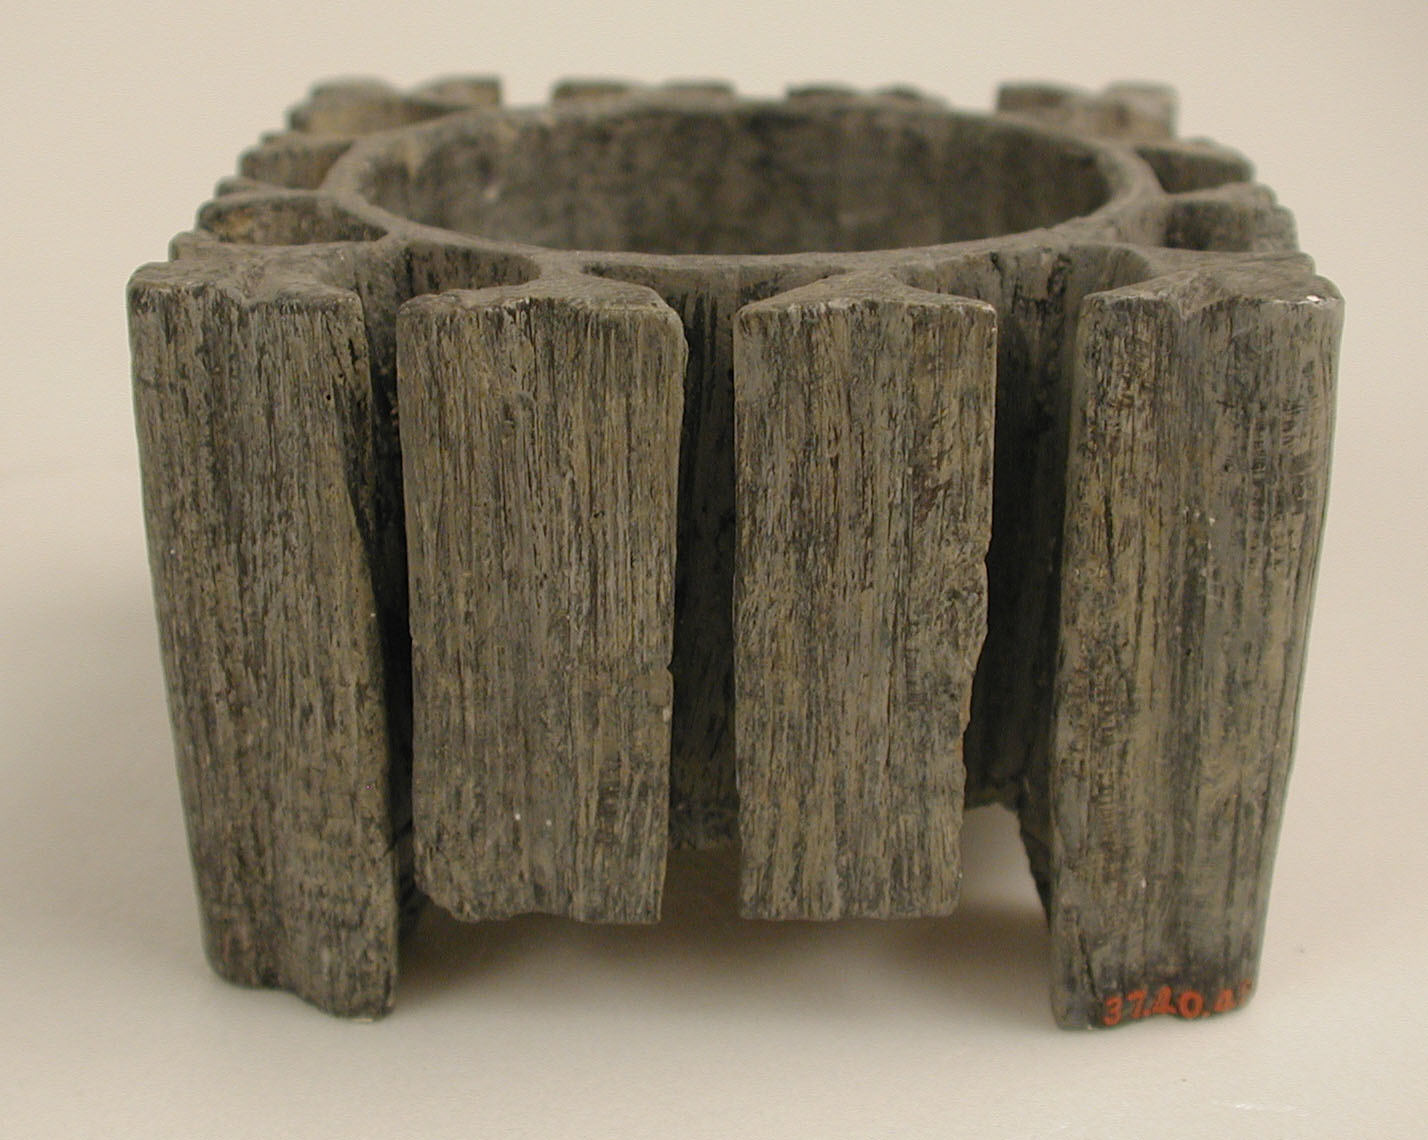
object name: lamp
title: Stone Oil Lamp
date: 801-1000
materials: stone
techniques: carving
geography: iran